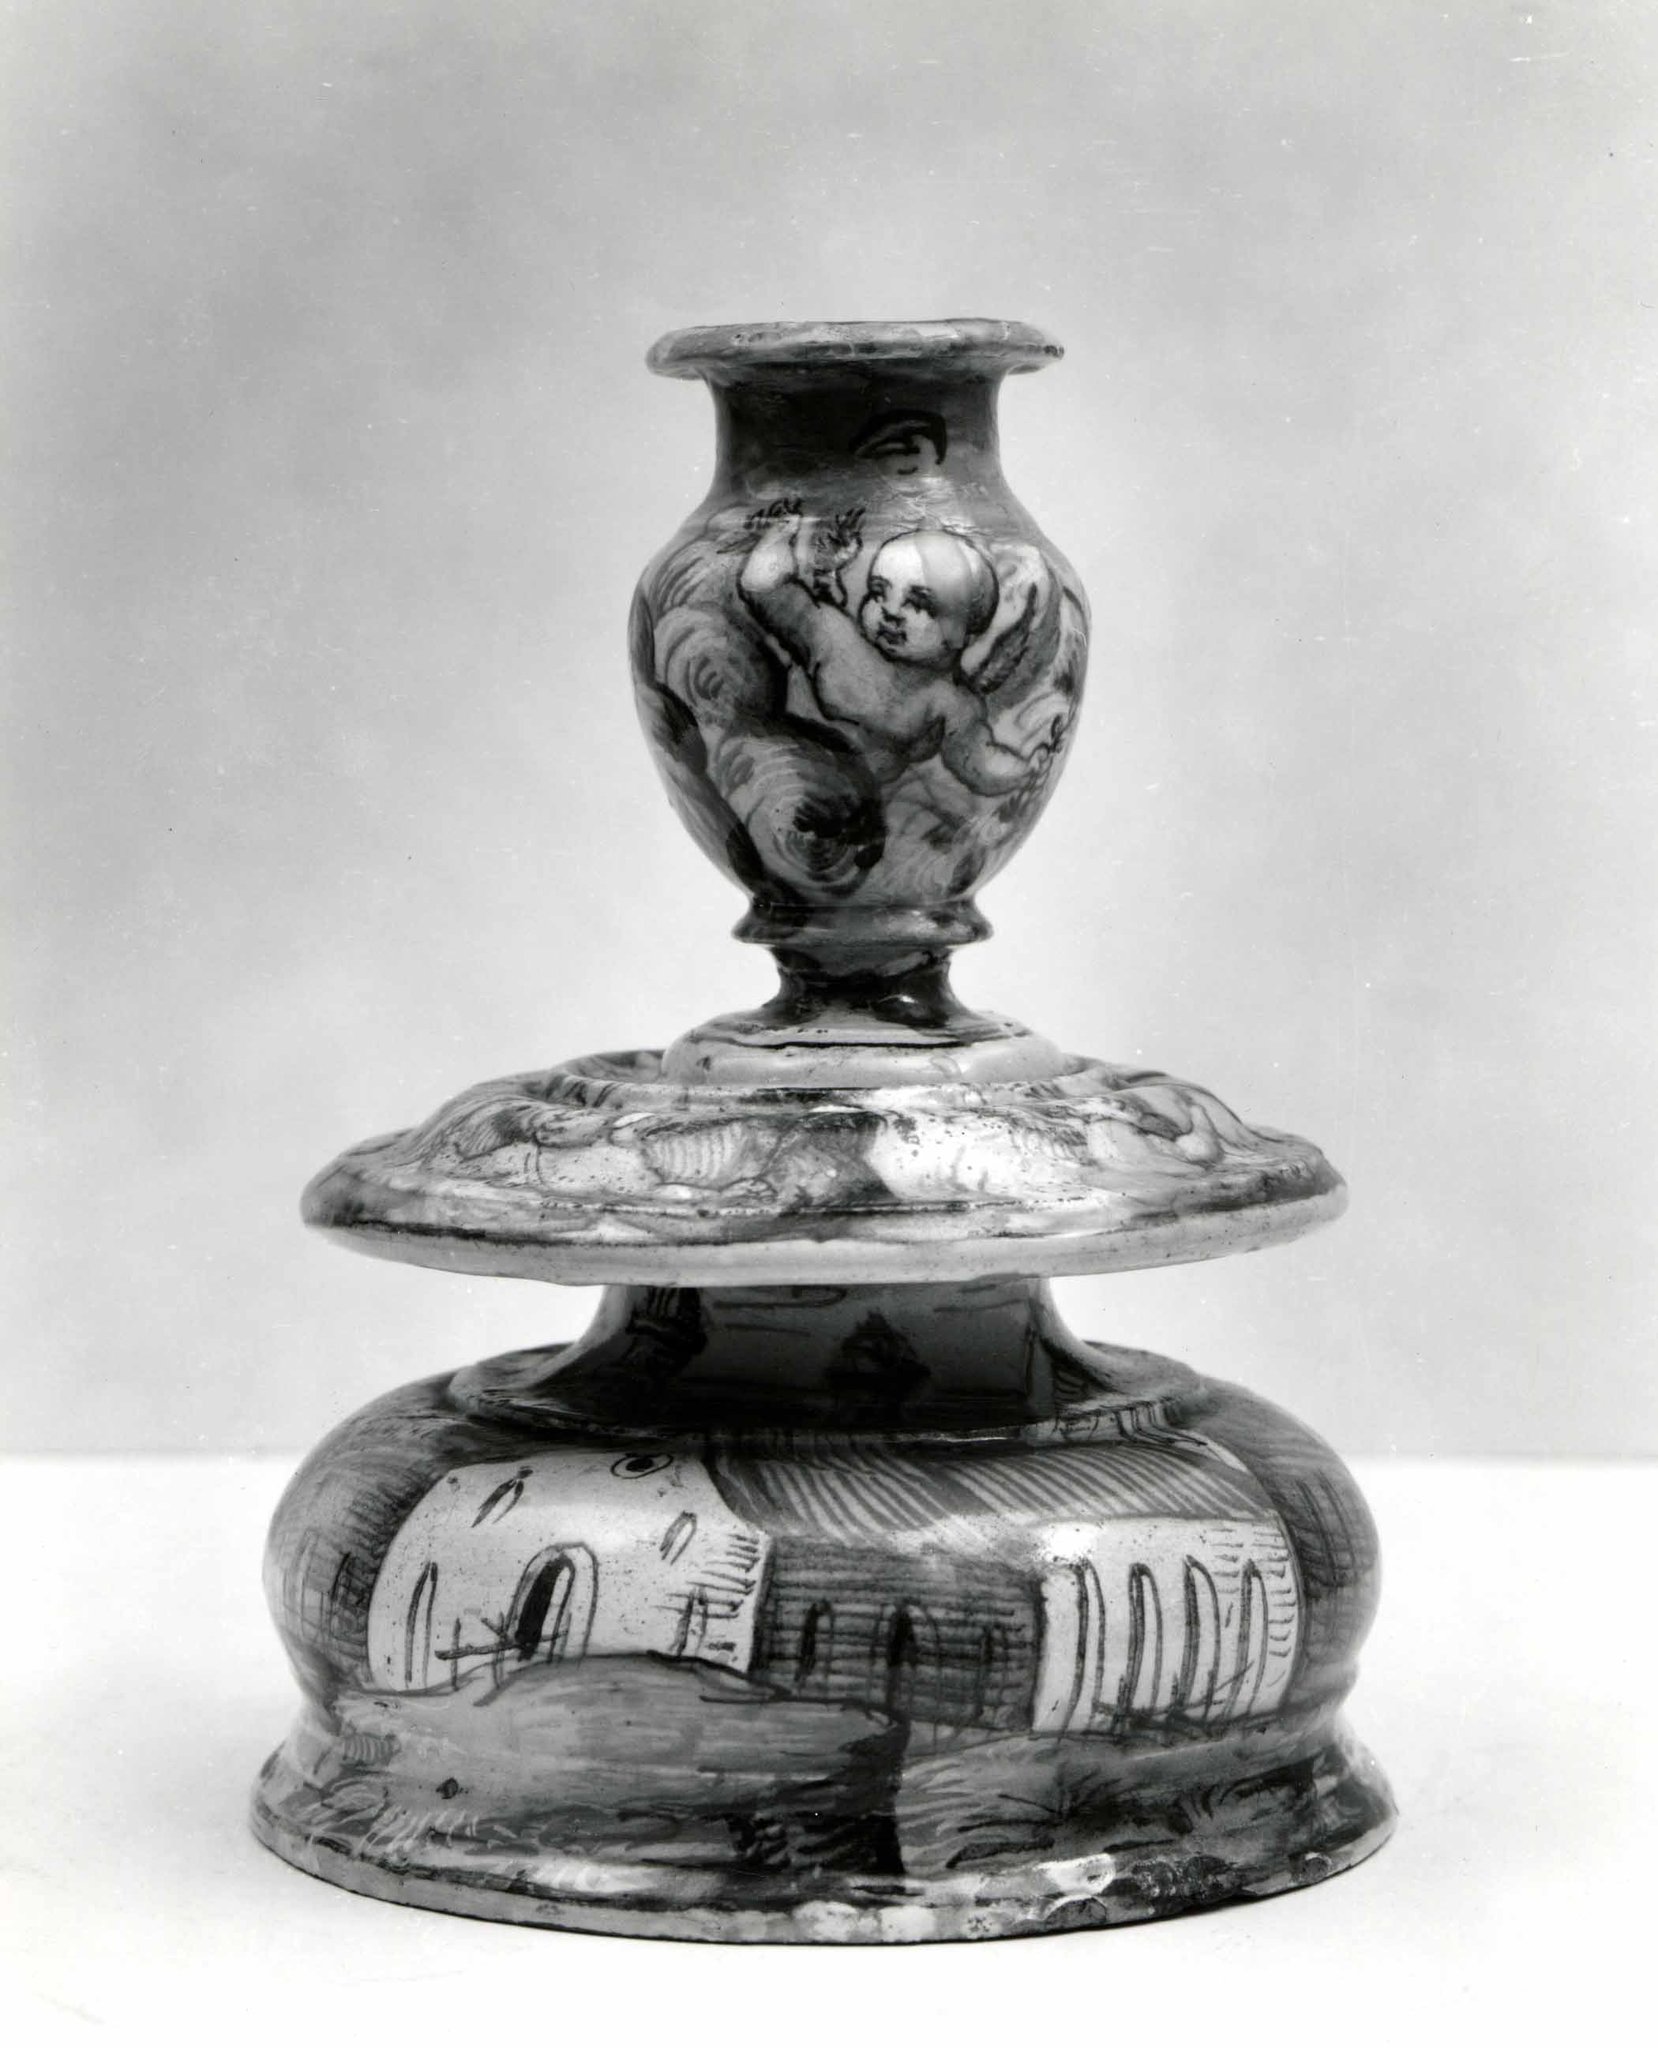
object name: candlestick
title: Candlestick (candeliere)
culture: italian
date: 1560-1580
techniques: maiolica, glazing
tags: putti